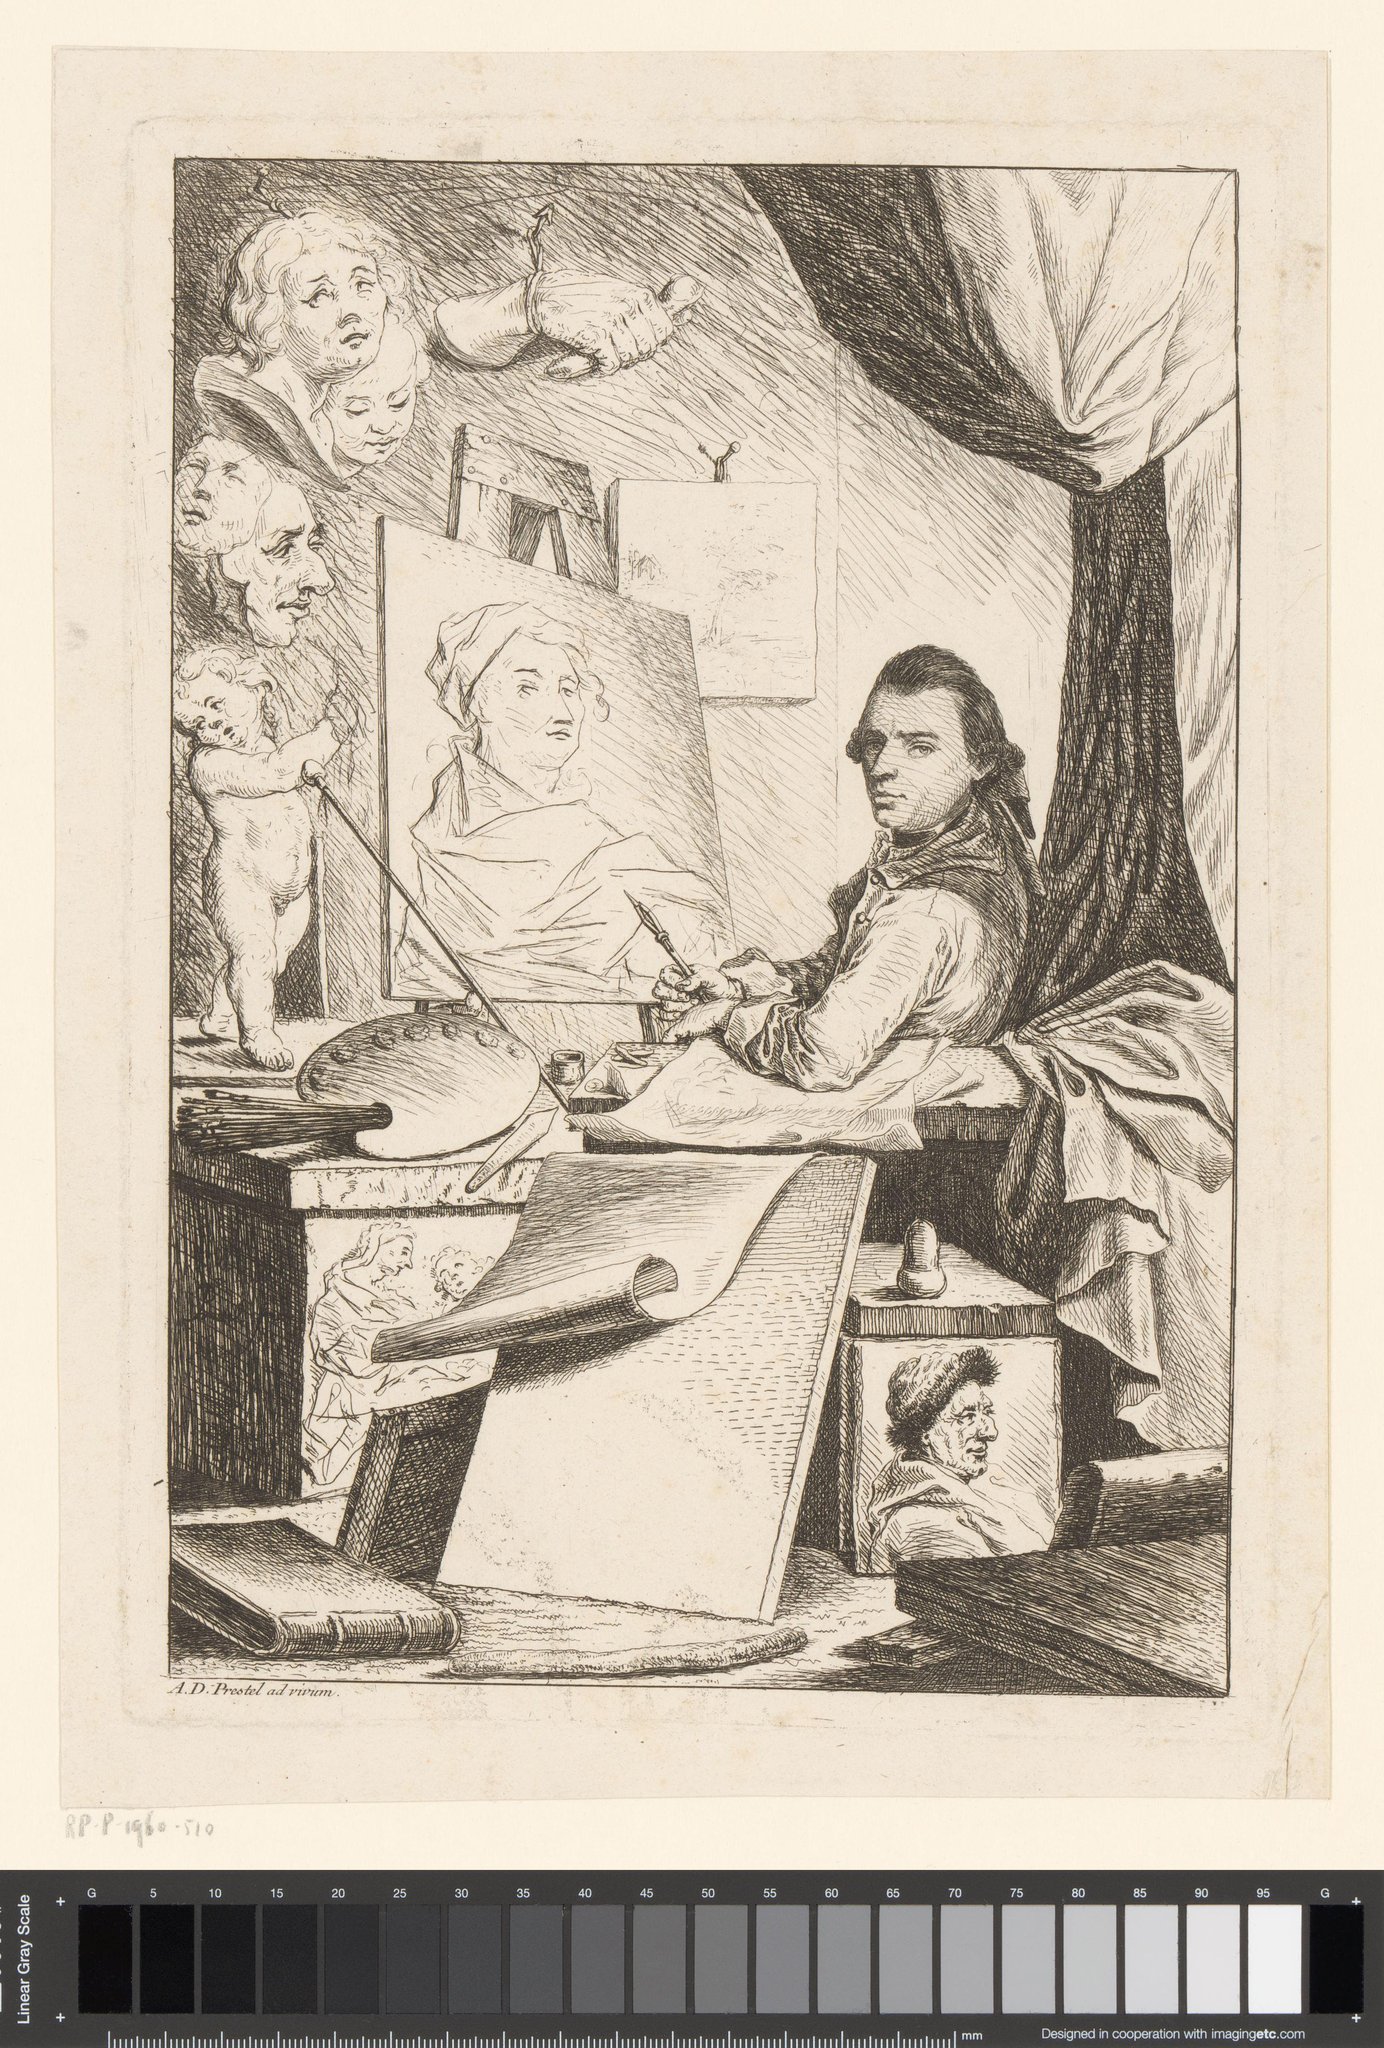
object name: print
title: Zelfportret voor de ezel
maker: johann gottlieb prestel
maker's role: draughtsman, painter, print maker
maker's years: 1739-1808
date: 1749-1808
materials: paper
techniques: etching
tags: painter, print maker, draughtsman, johann gottlieb prestel, tools, implements of painter, portrait, self-portrait of artist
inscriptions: collector's mark: Lugt 2228